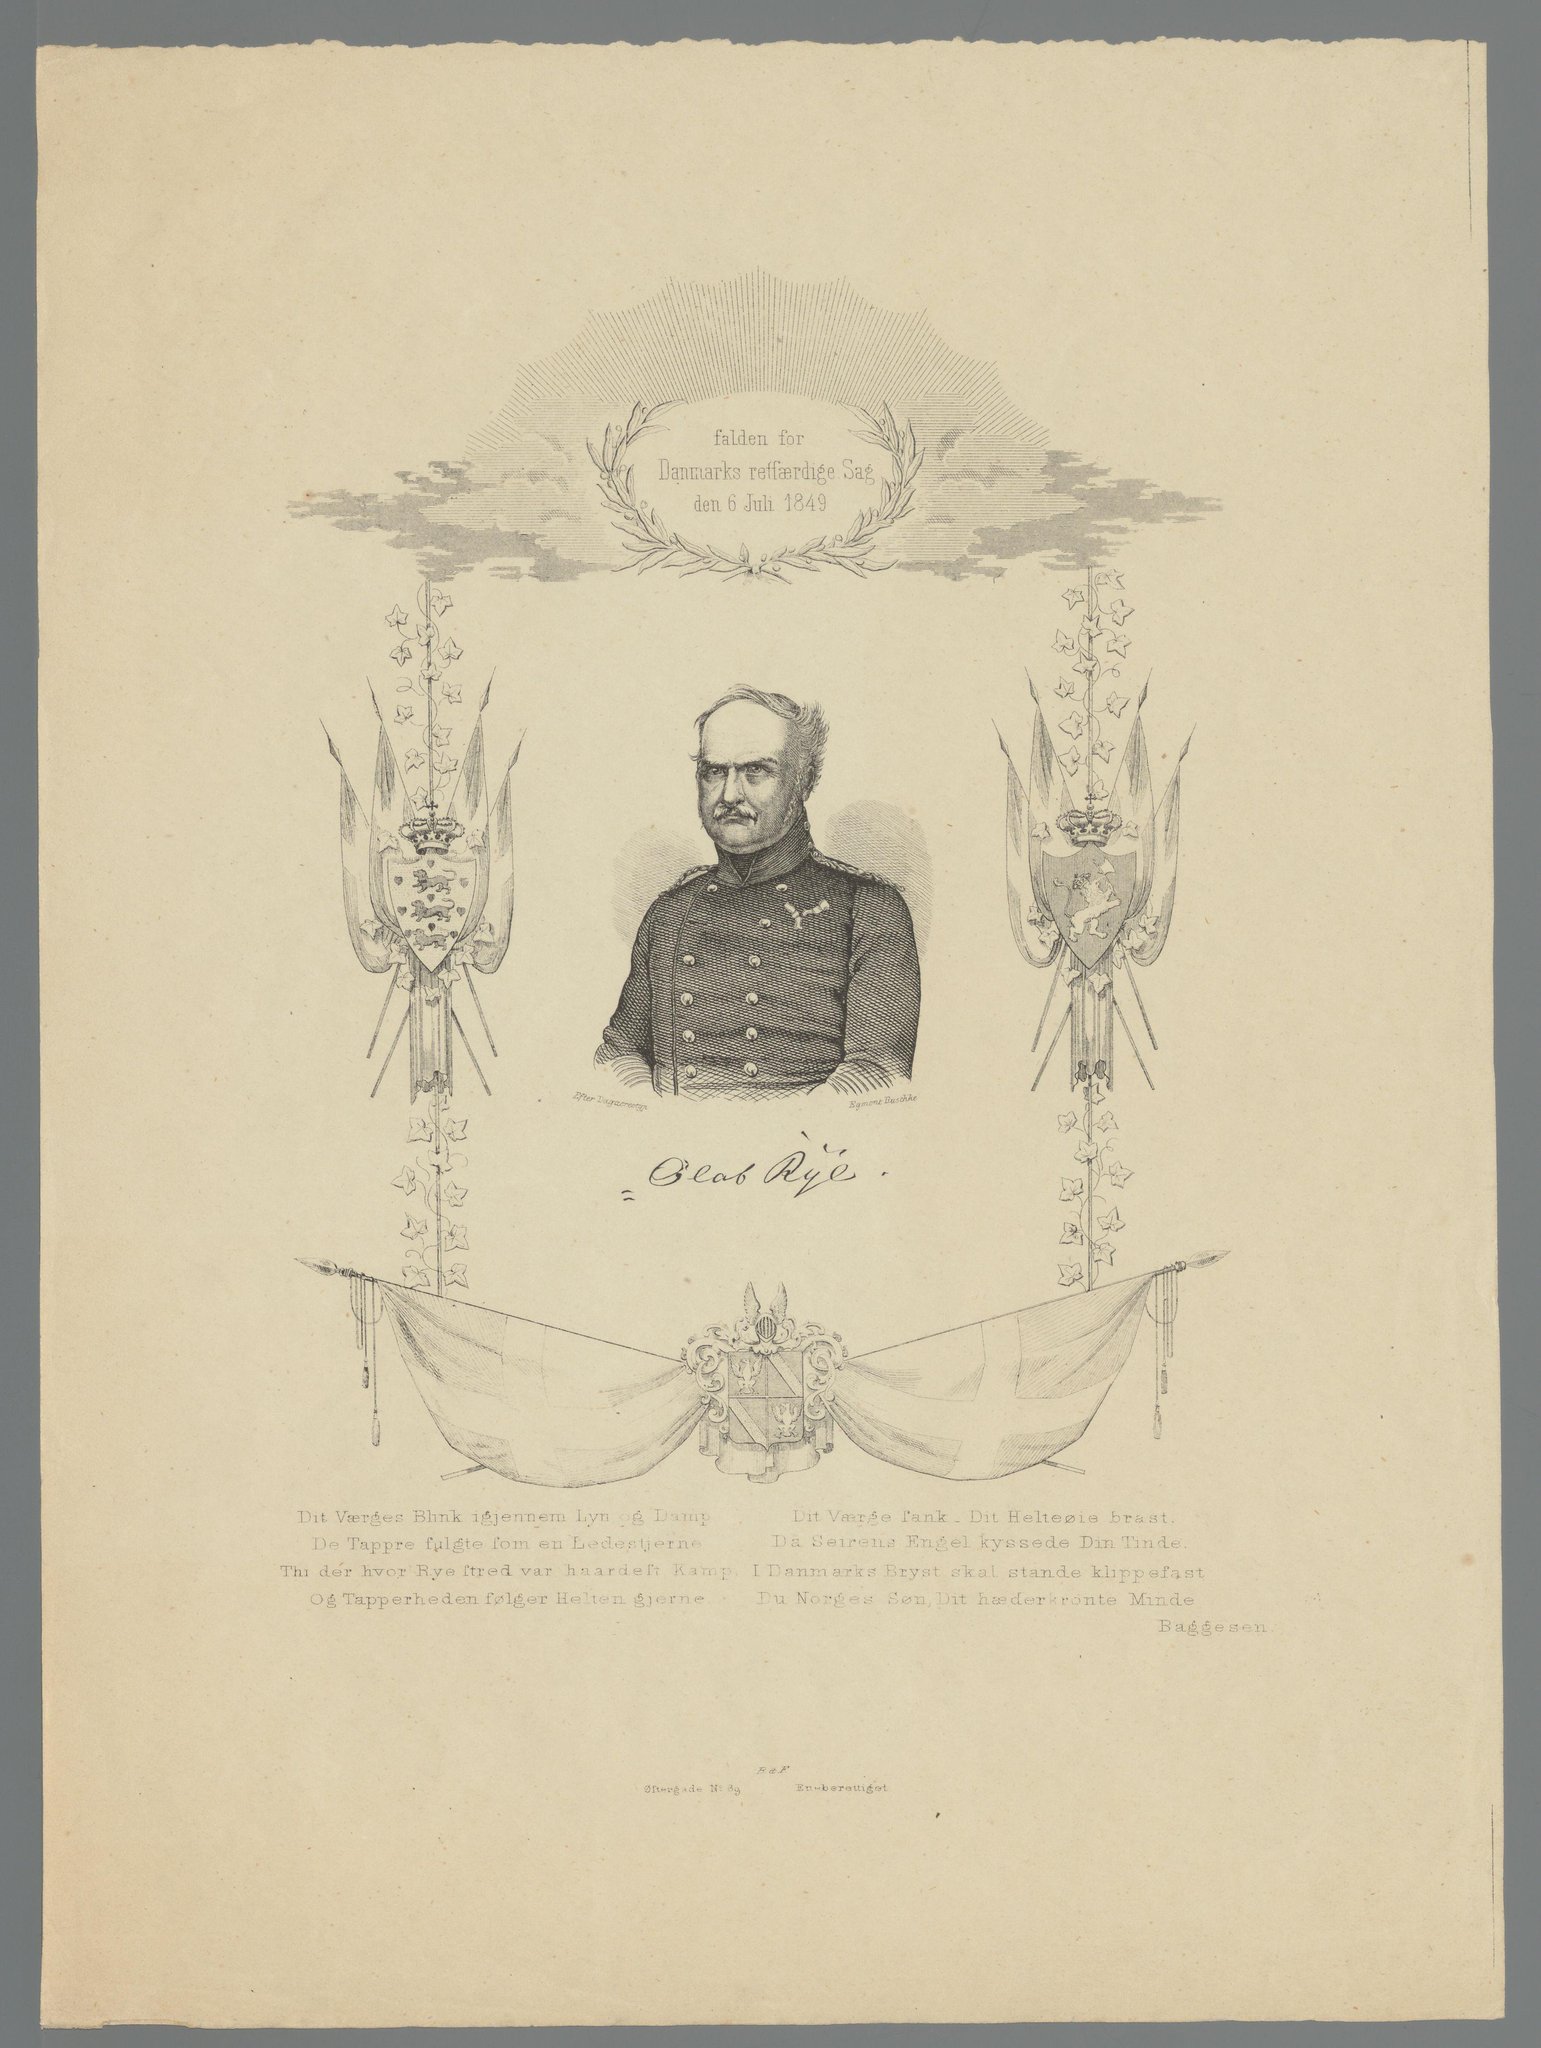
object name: print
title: Portret van Olaf Rye met omlijsting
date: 1849-1899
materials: paper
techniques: lithograph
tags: adult man, historical persons, (military) uniforms, military clothing and other equipment (uniforms, cap, armour, helmet, etc.)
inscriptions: collector's mark: Lugt 2228, inscription: ‘B&F, Ostergade No. 69, Eneberettiget’